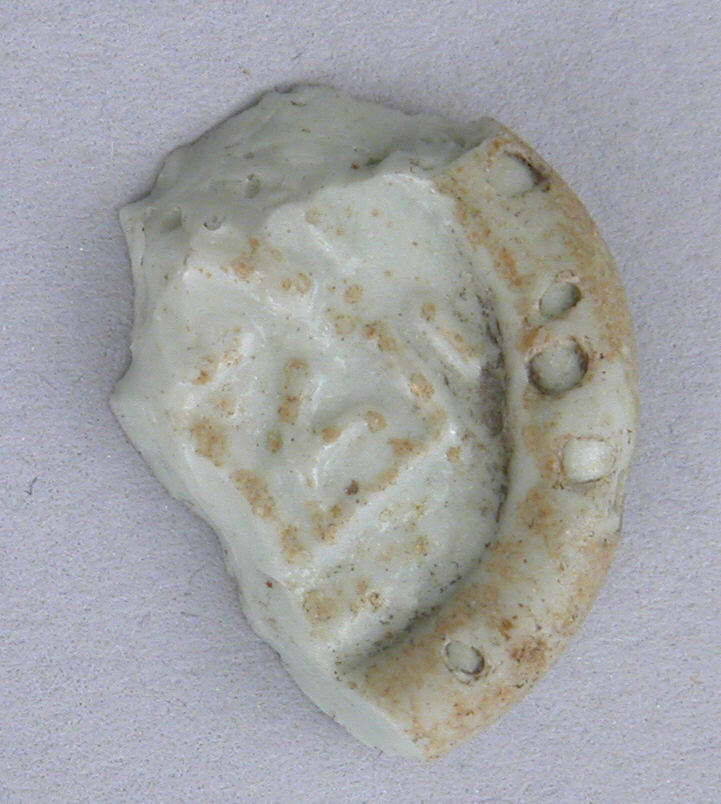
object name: coin weight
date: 1101-1200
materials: glass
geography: egypt